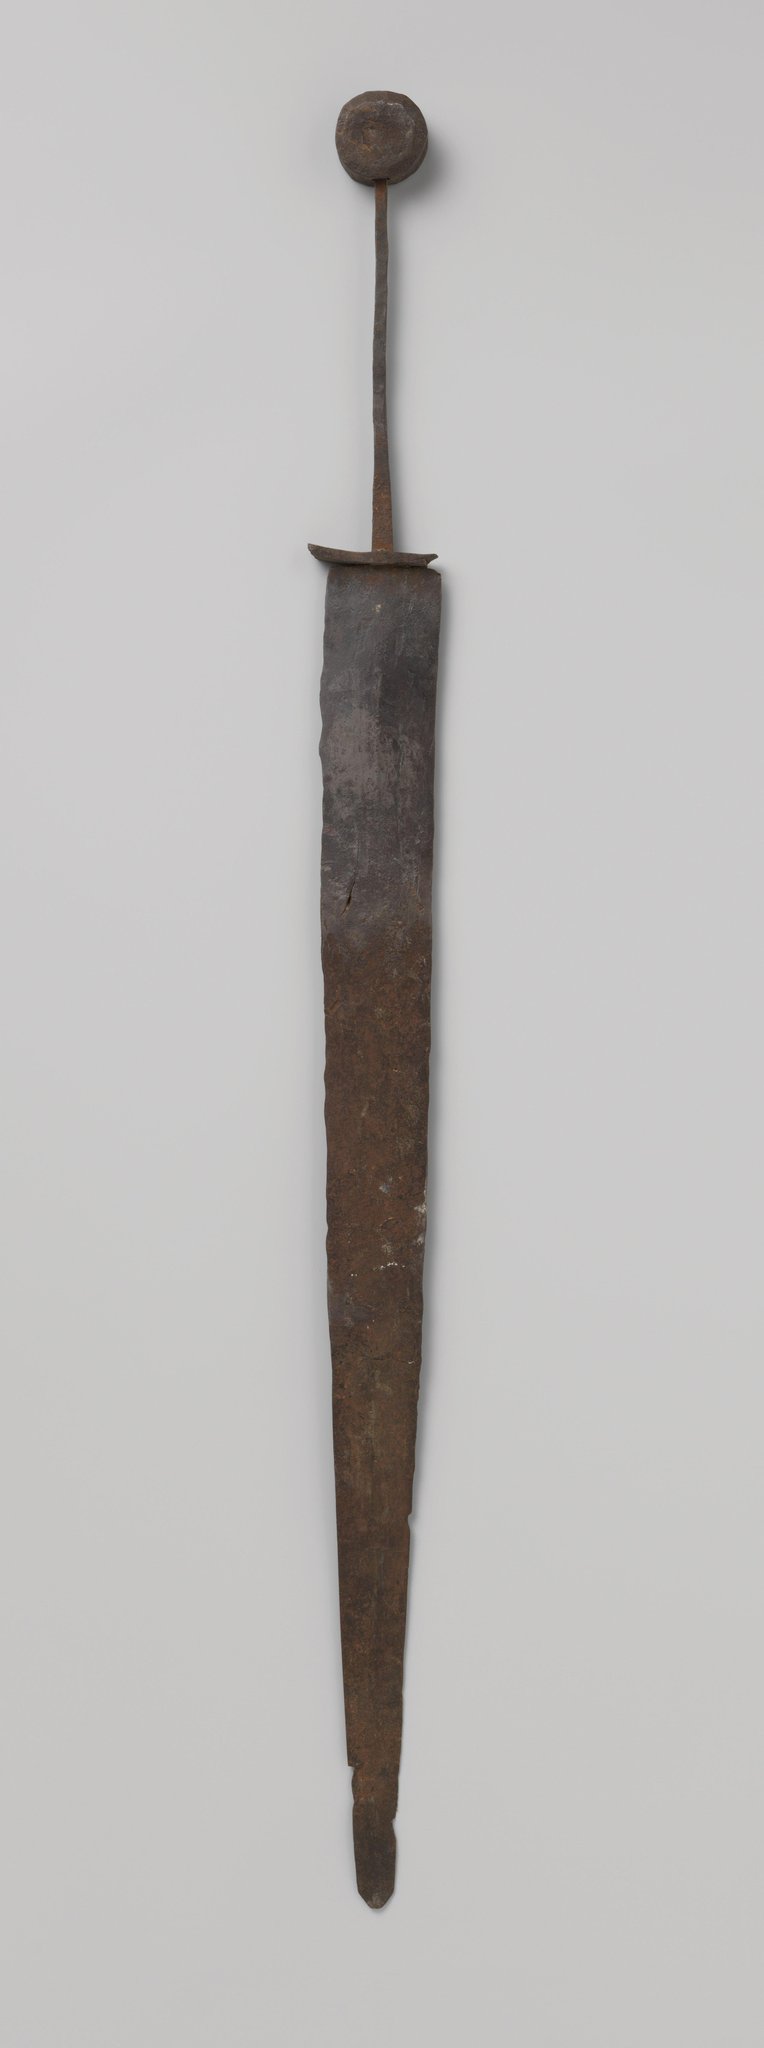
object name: sword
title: IJzeren zwaard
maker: Anonymous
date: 1200-1300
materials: iron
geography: western europe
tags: nijmegen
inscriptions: number: ‘N.G.132.’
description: IJzeren zwaard, tweesnijdend, de greep met aan weerszijden afgebroken rechte pareerstang, eindigt in een grote ronde knop, en is enigszins krom gebogen. De omwoeling ontbreekt.